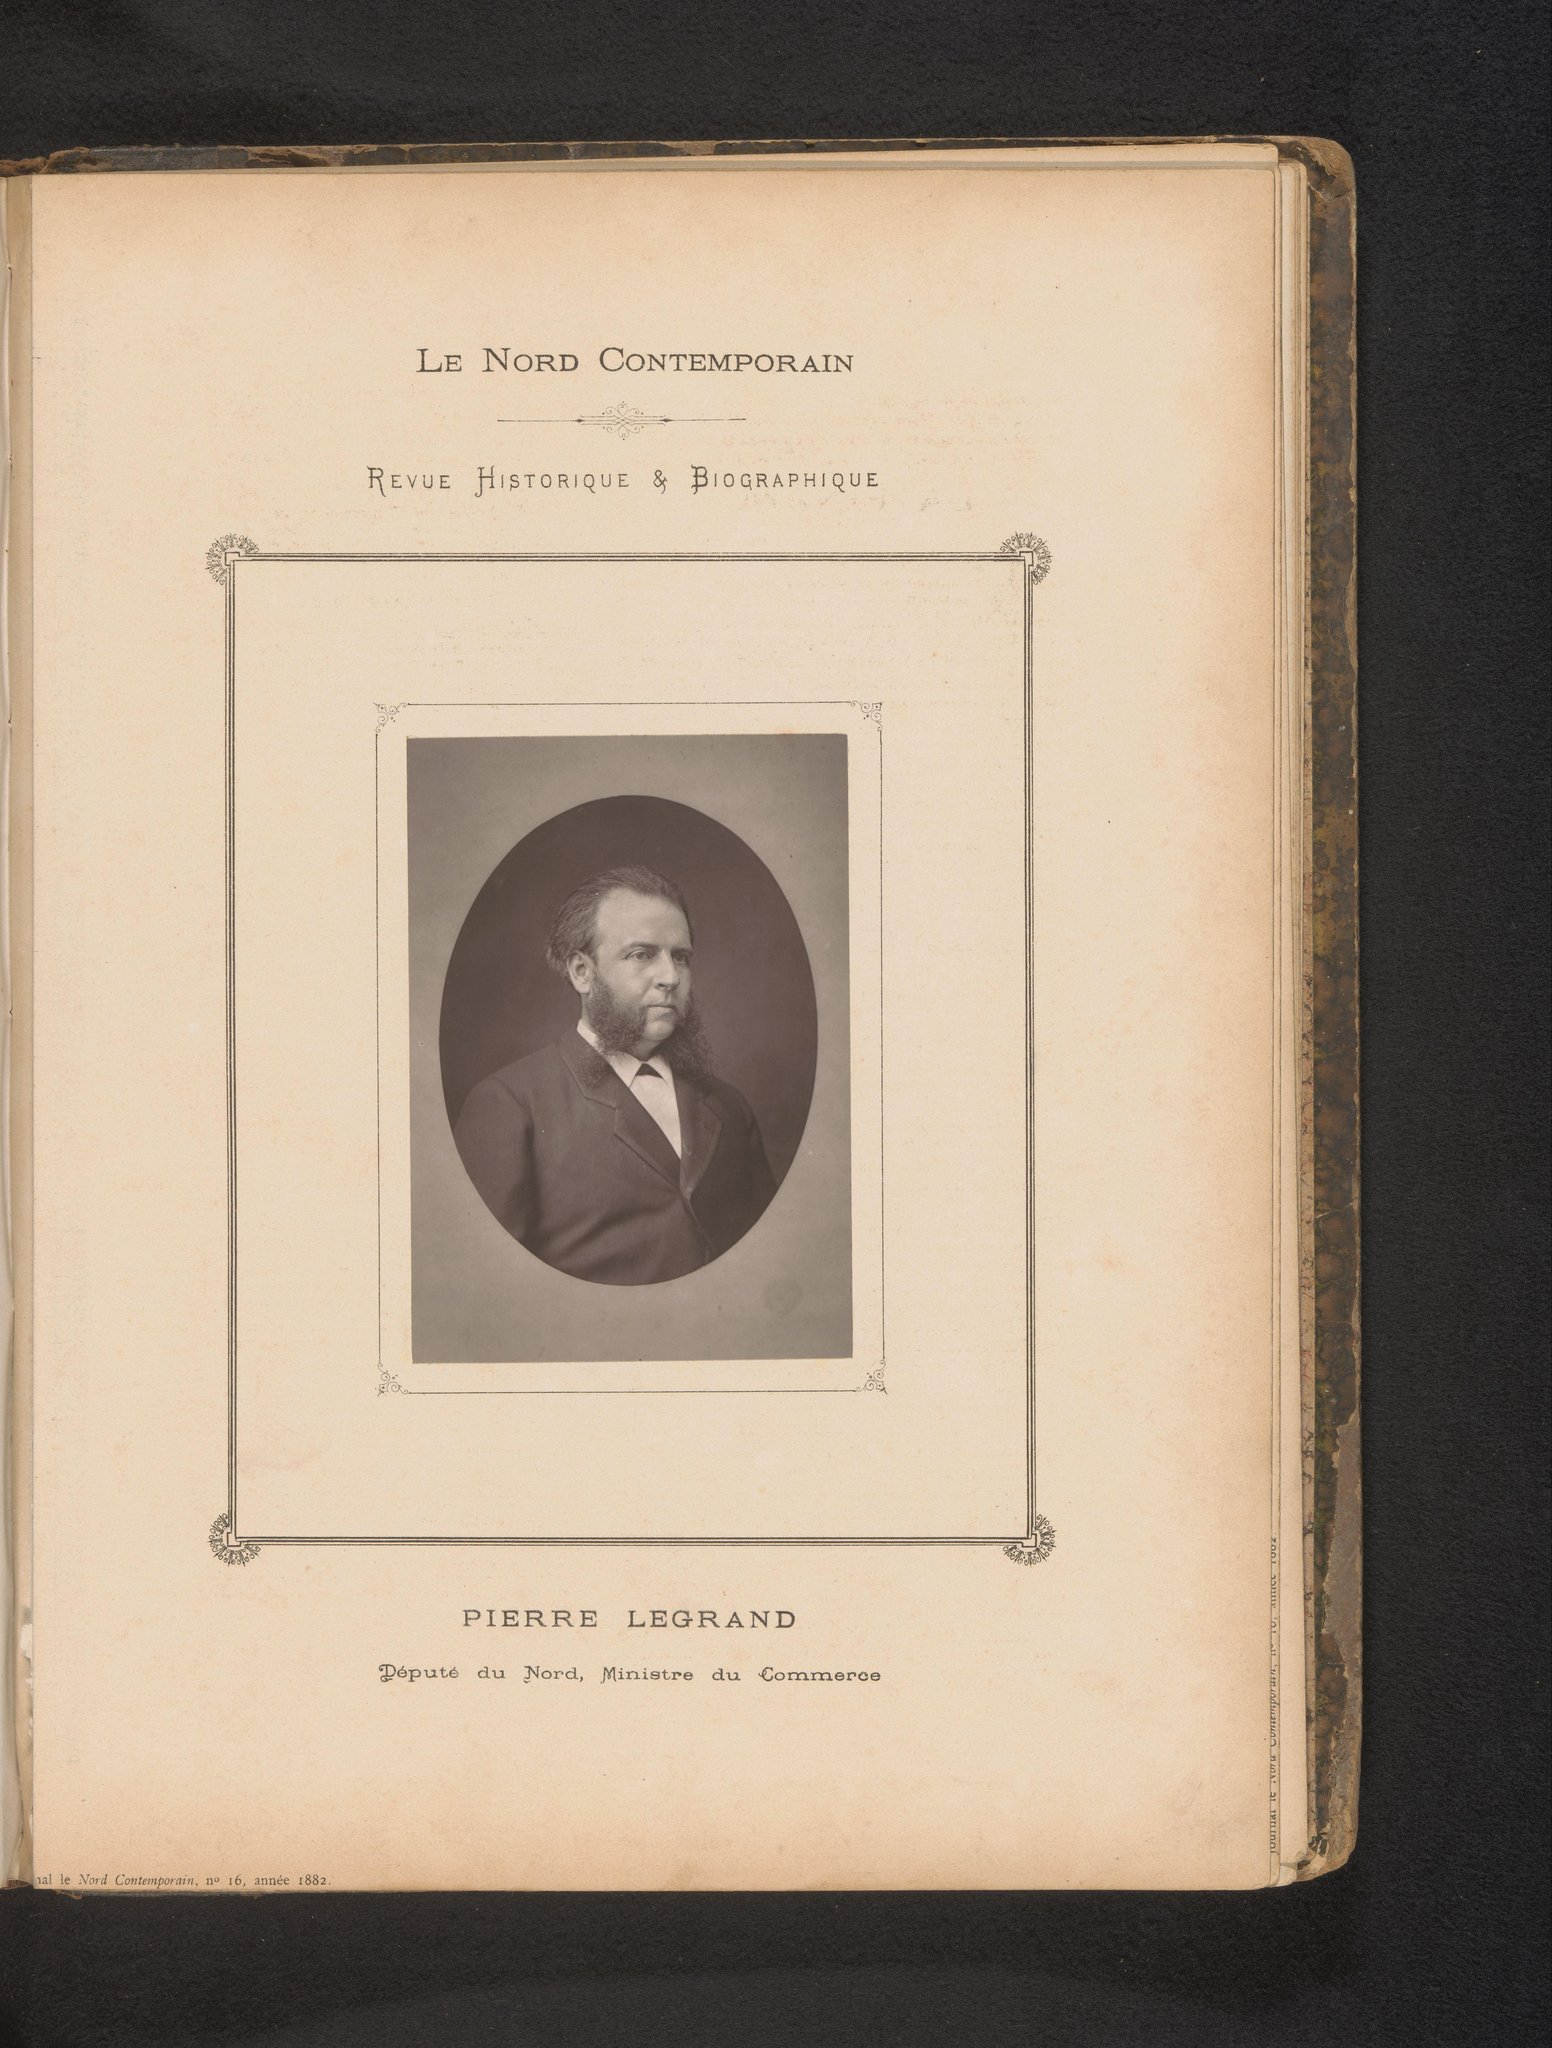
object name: photomechanical print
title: Pierre Legrand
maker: Anonymous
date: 1878-1882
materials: paper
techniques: woodburytype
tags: lille, politician, historical persons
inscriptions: inscription: ‘Le Nord Contemporain/ Revue Historique & Biographique’, inscription: ‘(La Bourse & la Mairie)’, inscription: ‘Journal le Nord Contemporain, No 16, année 1882’